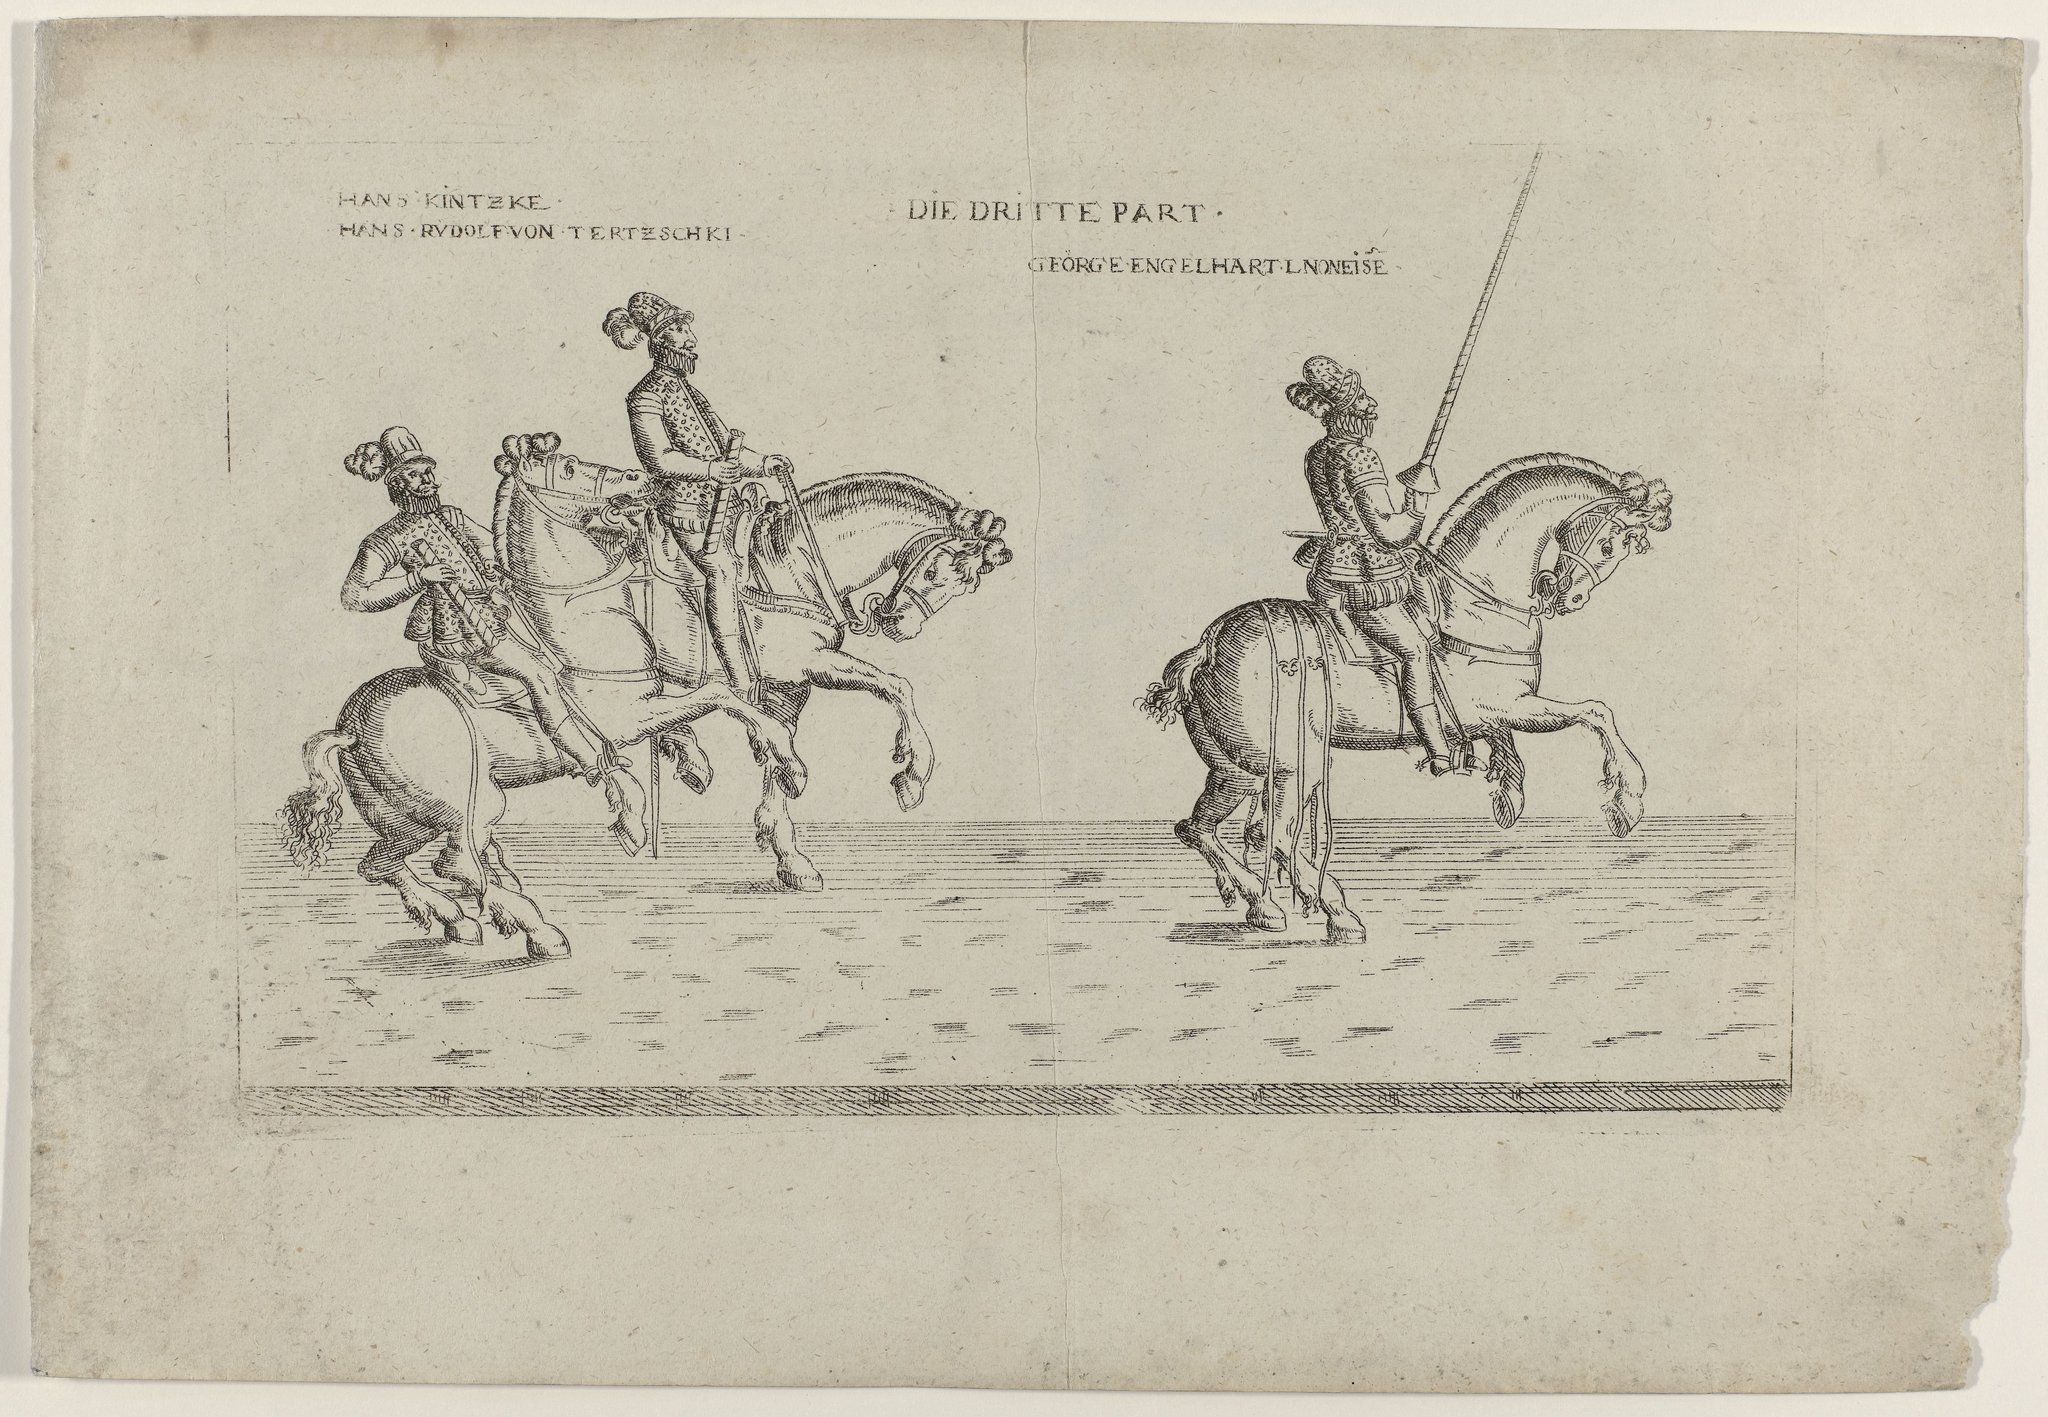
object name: print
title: Die dritte Part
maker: Anonymous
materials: paper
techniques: etching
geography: germany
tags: riding a horse, ass, or mule; rider, horseman, dress-up party, rejoicing on special occasions (+ parade, pageant, cavalcade ~ festive activities)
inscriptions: collector's mark: Lugt 2228, collector's mark: Lugt 2760, collector's mark: Lugt 2760